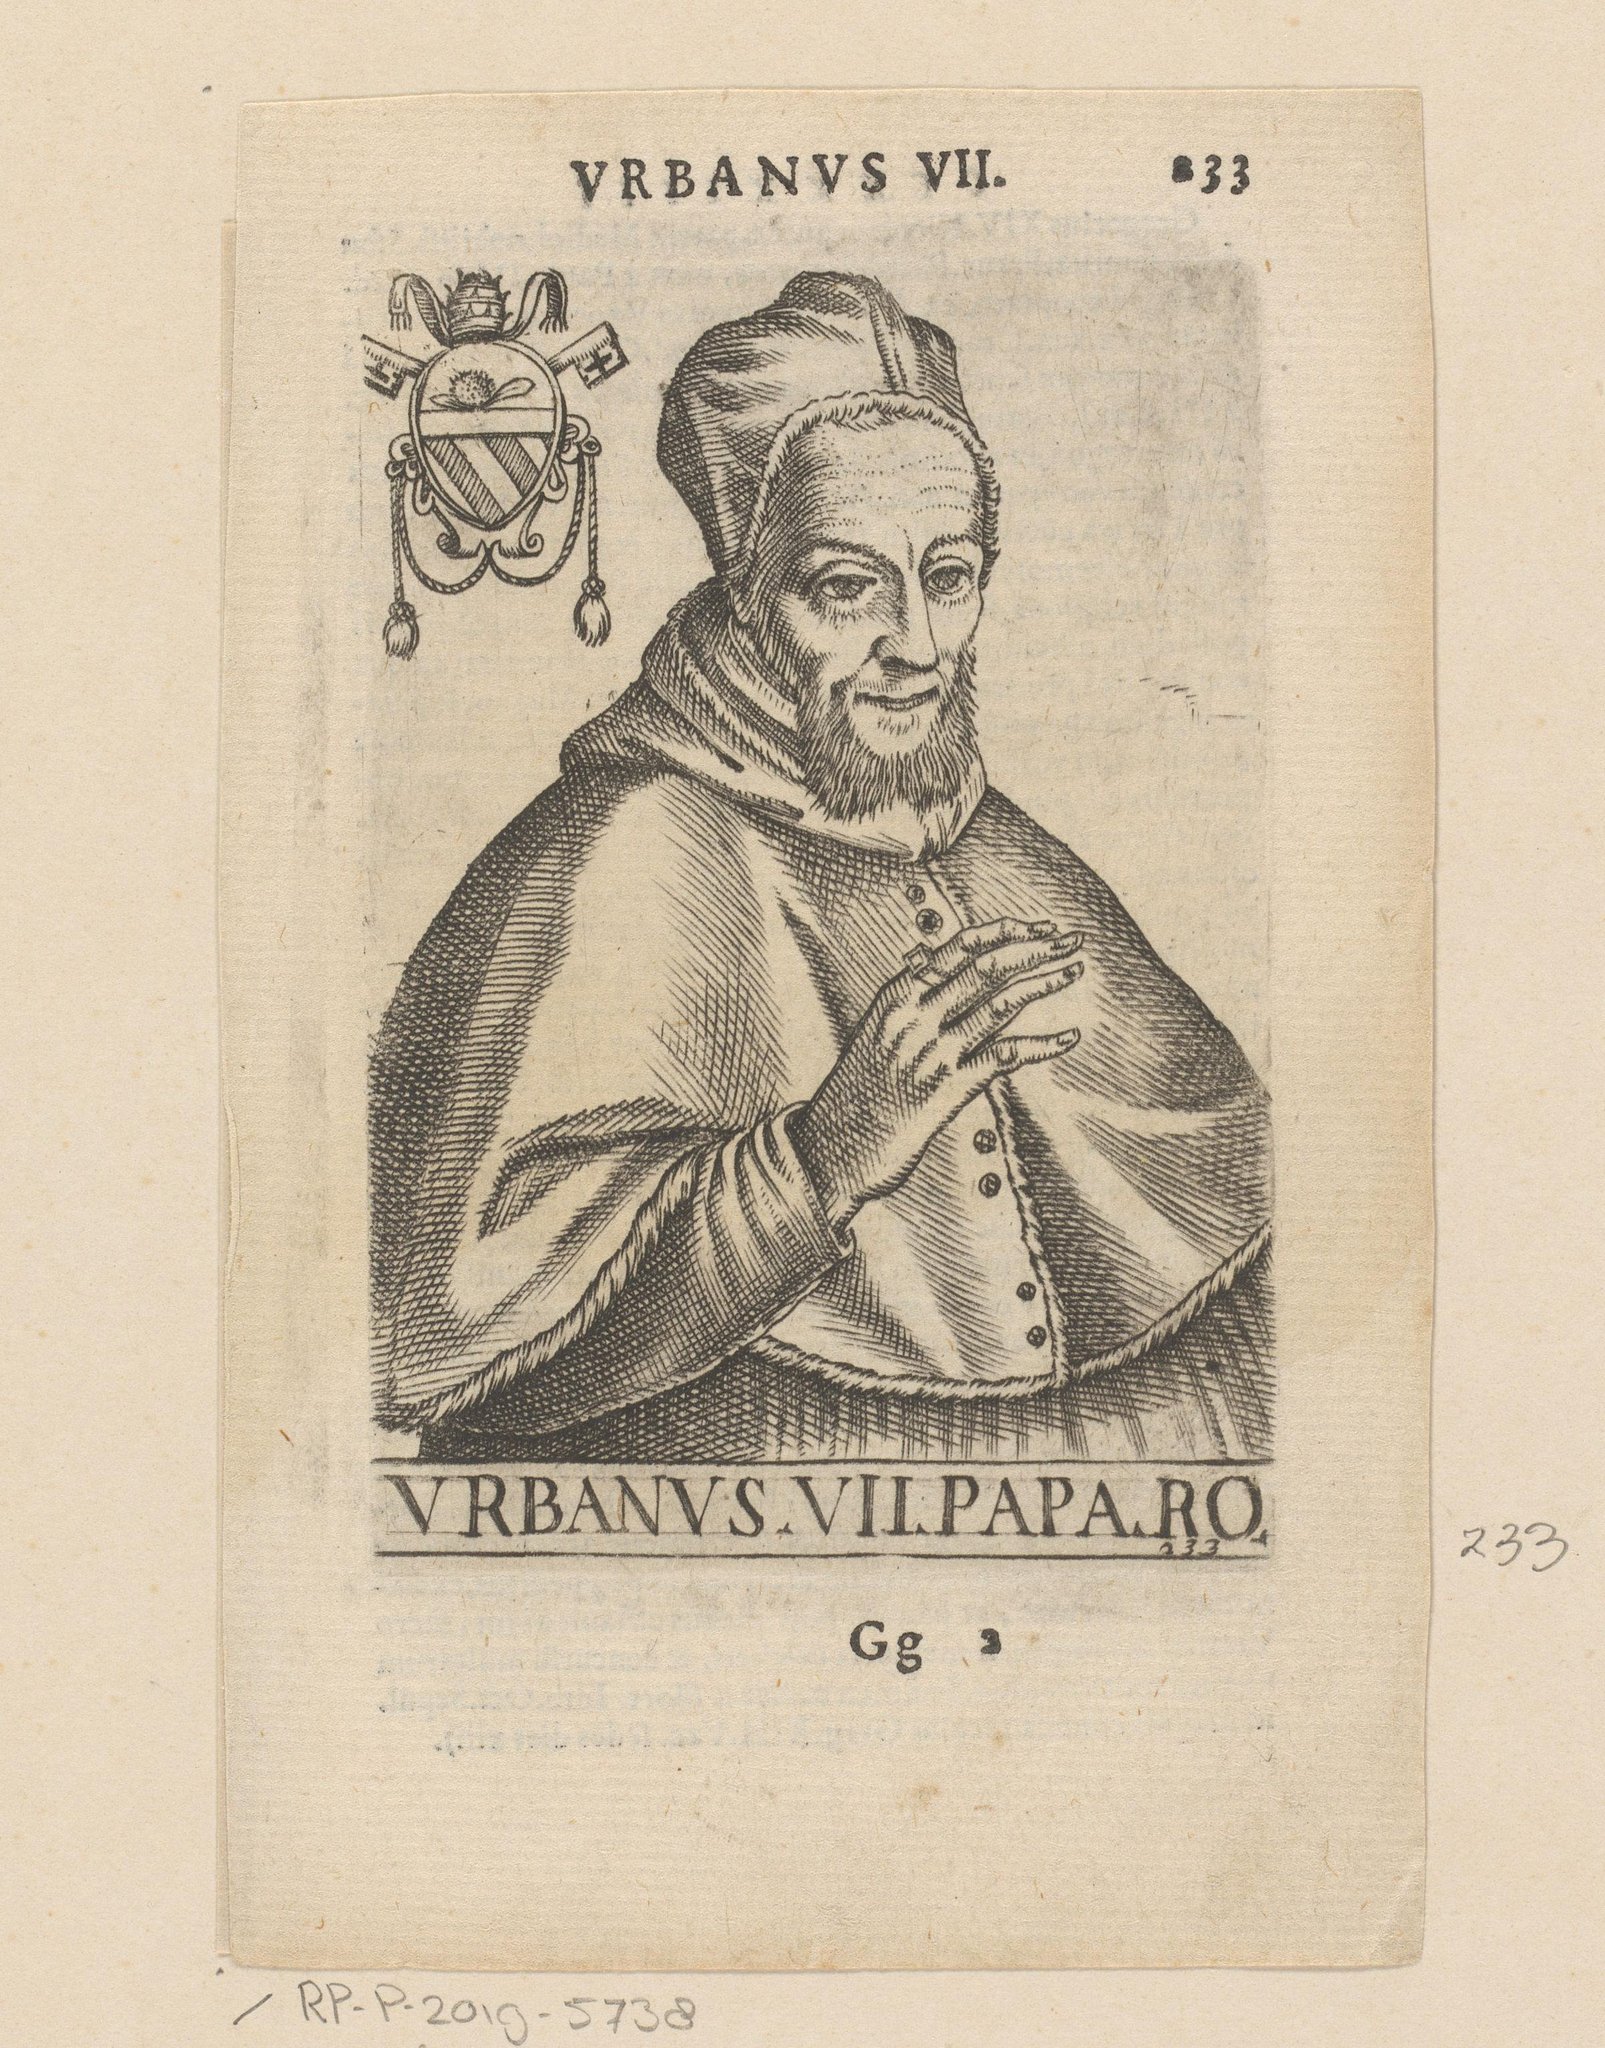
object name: print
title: Portret van paus Urbanus VII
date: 1595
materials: paper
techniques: engraving, letterpress printing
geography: rome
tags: rome, historical persons, pope, armorial bearing, heraldry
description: Prent uit: Cavalieri, Giovanni Battista de'. Effigies pontificum romanorum cum eorum vitis (...). Rome: Bartolomeo Bonfadino, 1595. Prent voor het eerst verschenen in: Cavalieri, Giovanni Battista de'. Pontificum romanorum effigies (...). Rome: Domenico Basa en Francesco Zanetti, 1580. Prent ook gebruikt in latere publicaties.